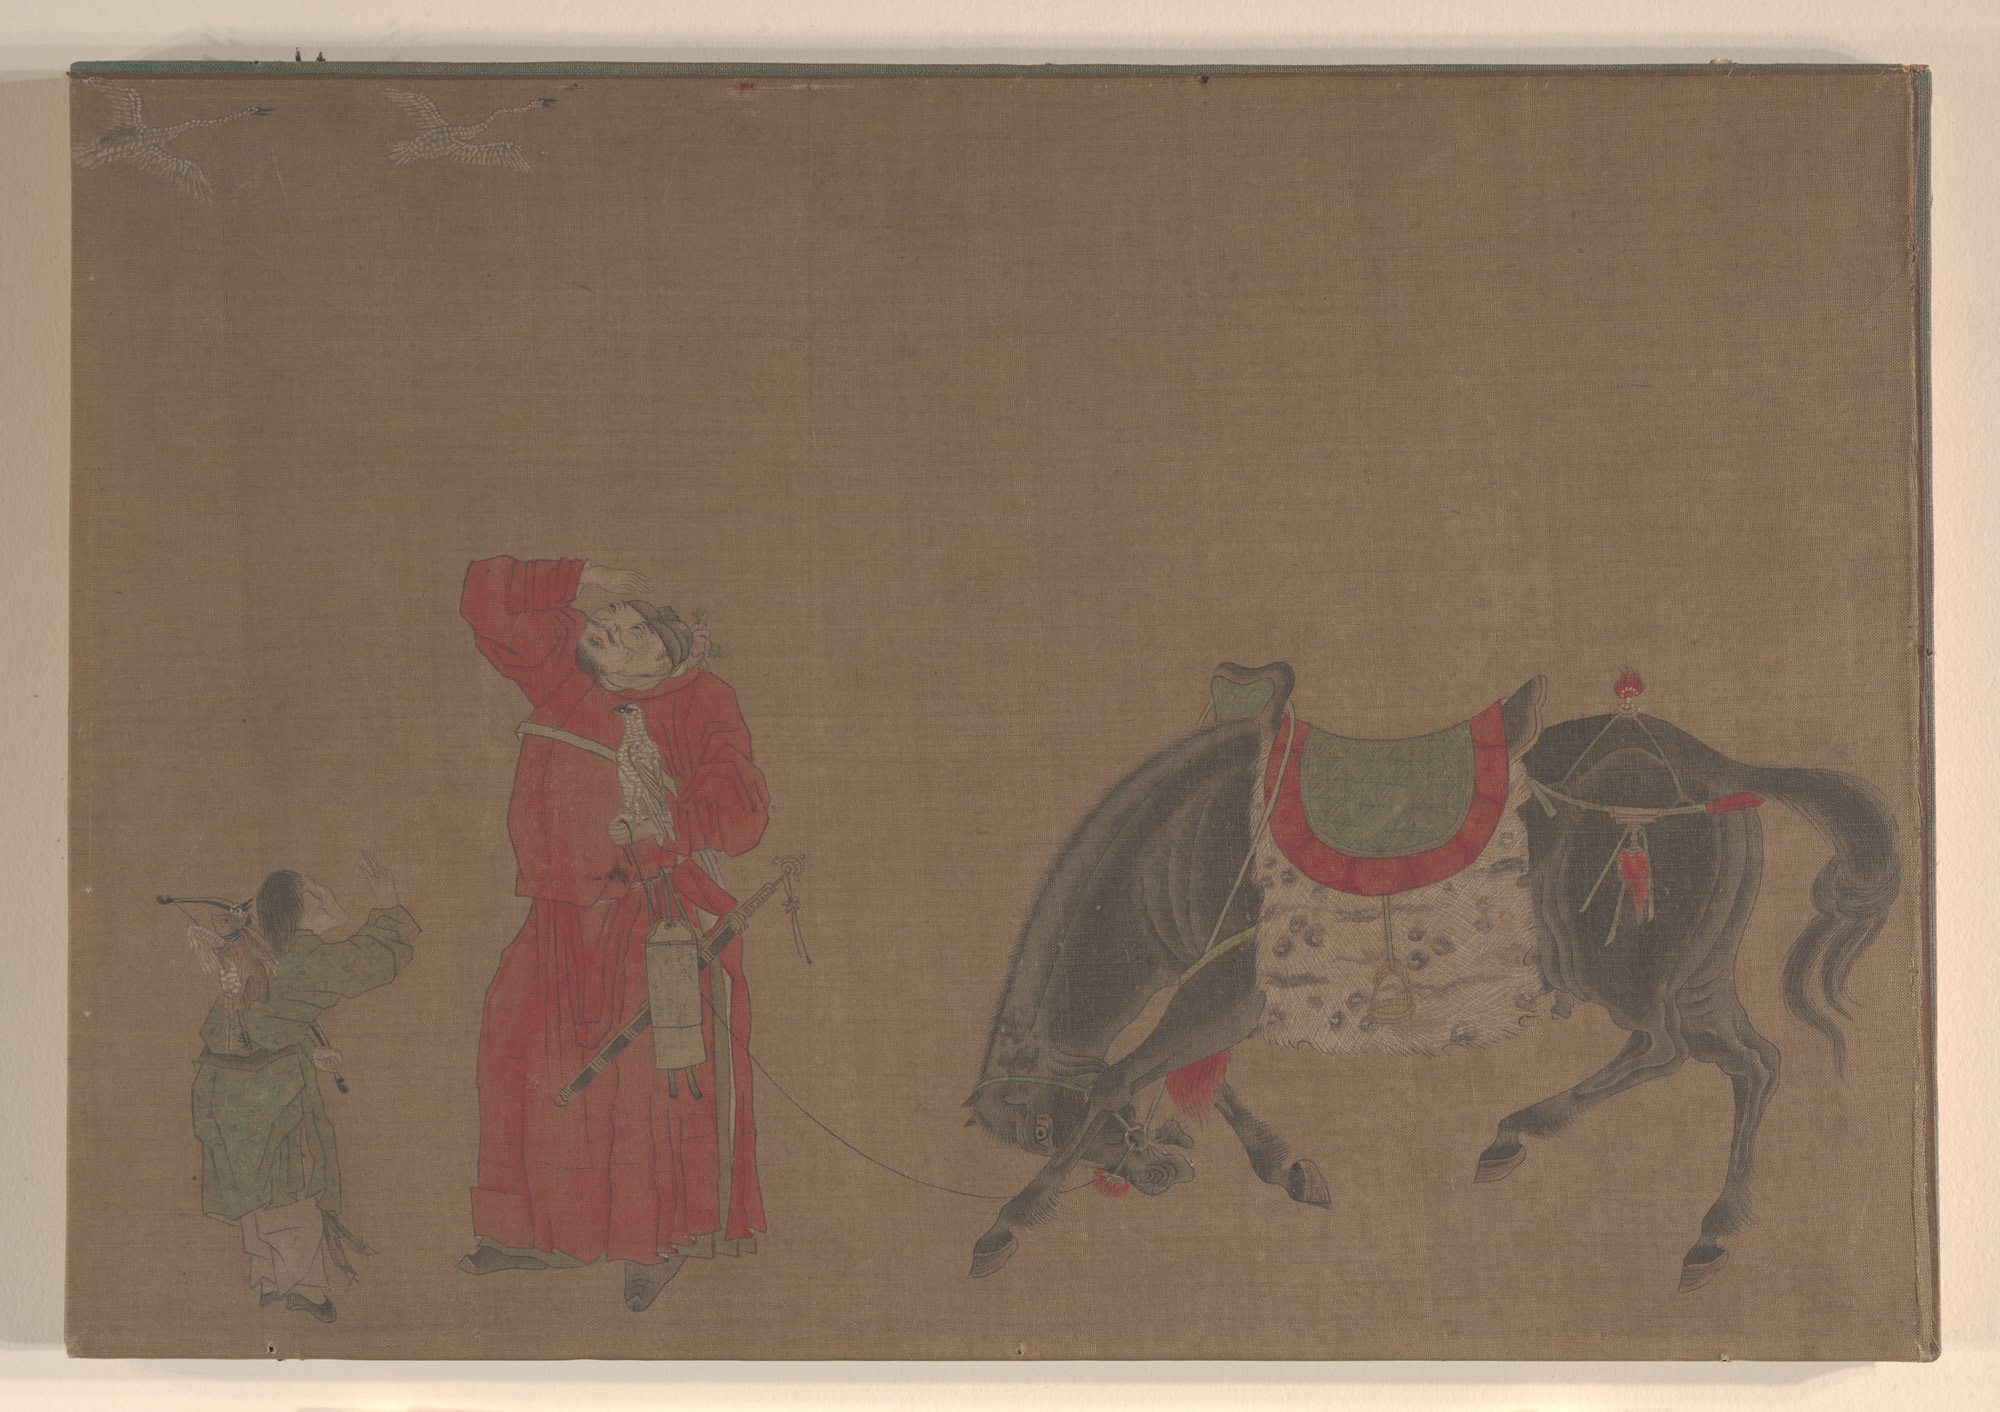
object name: album leaf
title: Hunter and Wild Geese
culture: chinese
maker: unidentified artist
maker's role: artist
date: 1368-1911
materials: ink, silk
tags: geese,men,horses